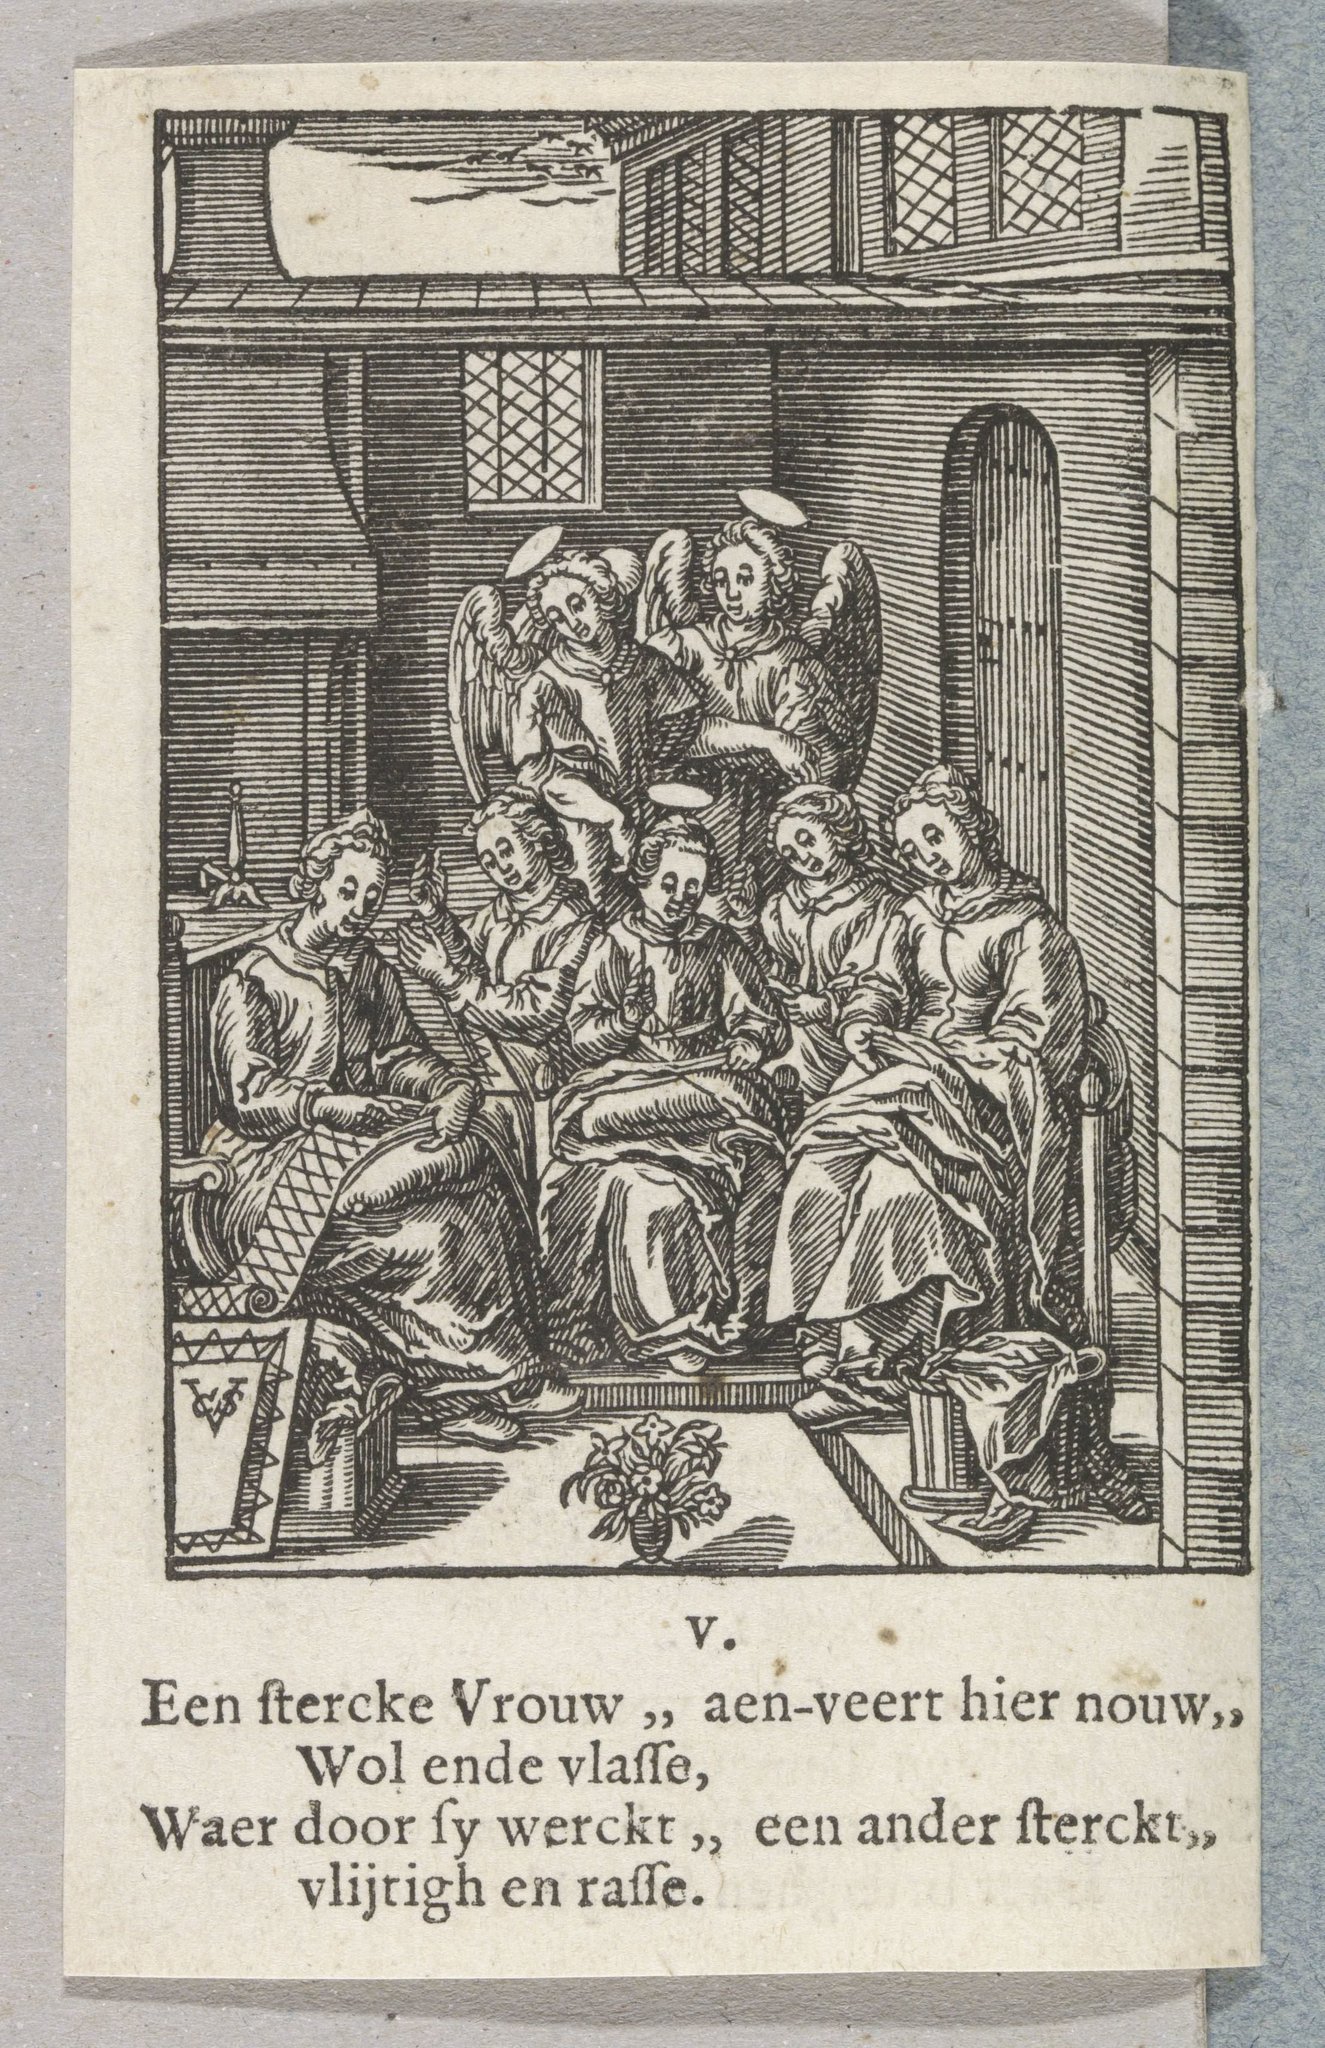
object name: book illustration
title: Jonge Maria als naaister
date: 1629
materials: paper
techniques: letterpress printing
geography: amsterdam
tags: other scenes ~ education of mary (+ angel(s)), sewing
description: De prent is mogelijk afkomstig uit: Der zielen lust-hof. Amsterdam, I. Jacobsz voor P.J. Paets [=Amsterdam, P.J. Paets], 1629; Het Nieuwe Testament De prent is afkomstig uit een van de uitgaven van P.J. Paets uit Amsterdam. De prent wordt voor het eerst gebruikt in: Der Zielen Lust-hof. Leuven, I.Jacbosz voor P.J. Paets [= Amsterdam, P.J. Paets], 1629.